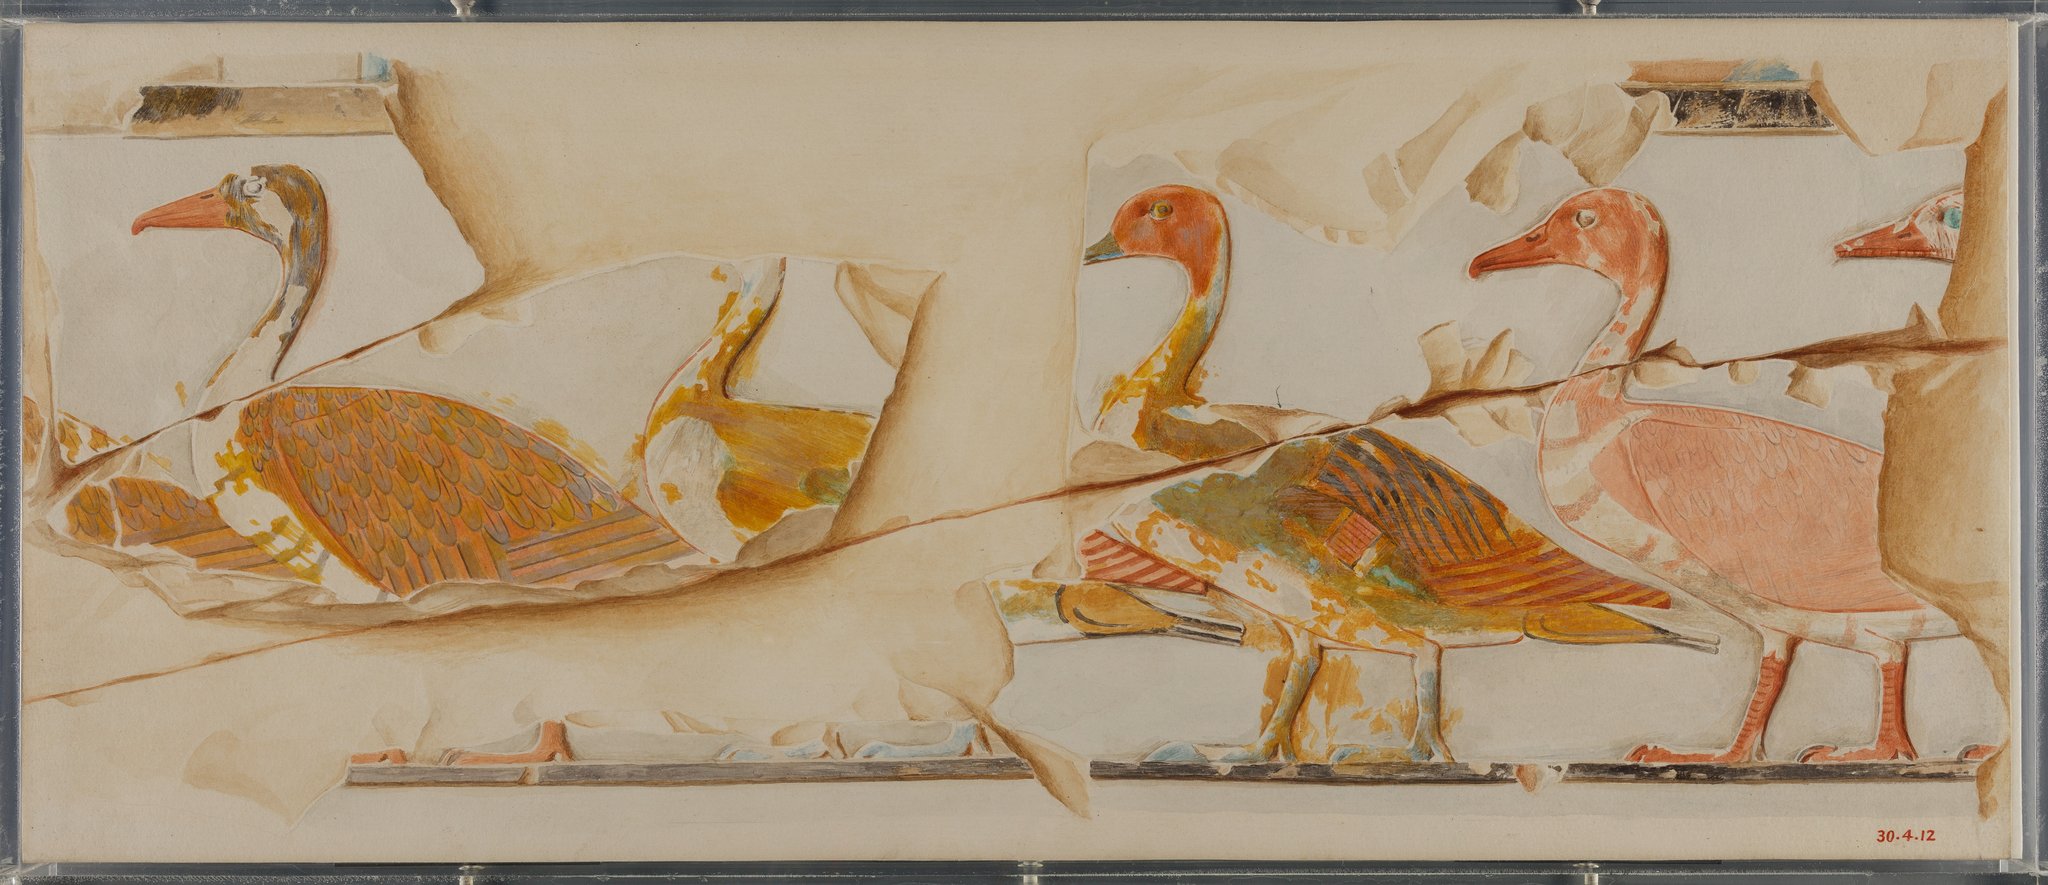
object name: facsimile, puyemre tt 39, duck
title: Geese and Ducks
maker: hugh r. hopgood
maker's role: artist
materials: paper, paint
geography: egypt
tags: love-poetry